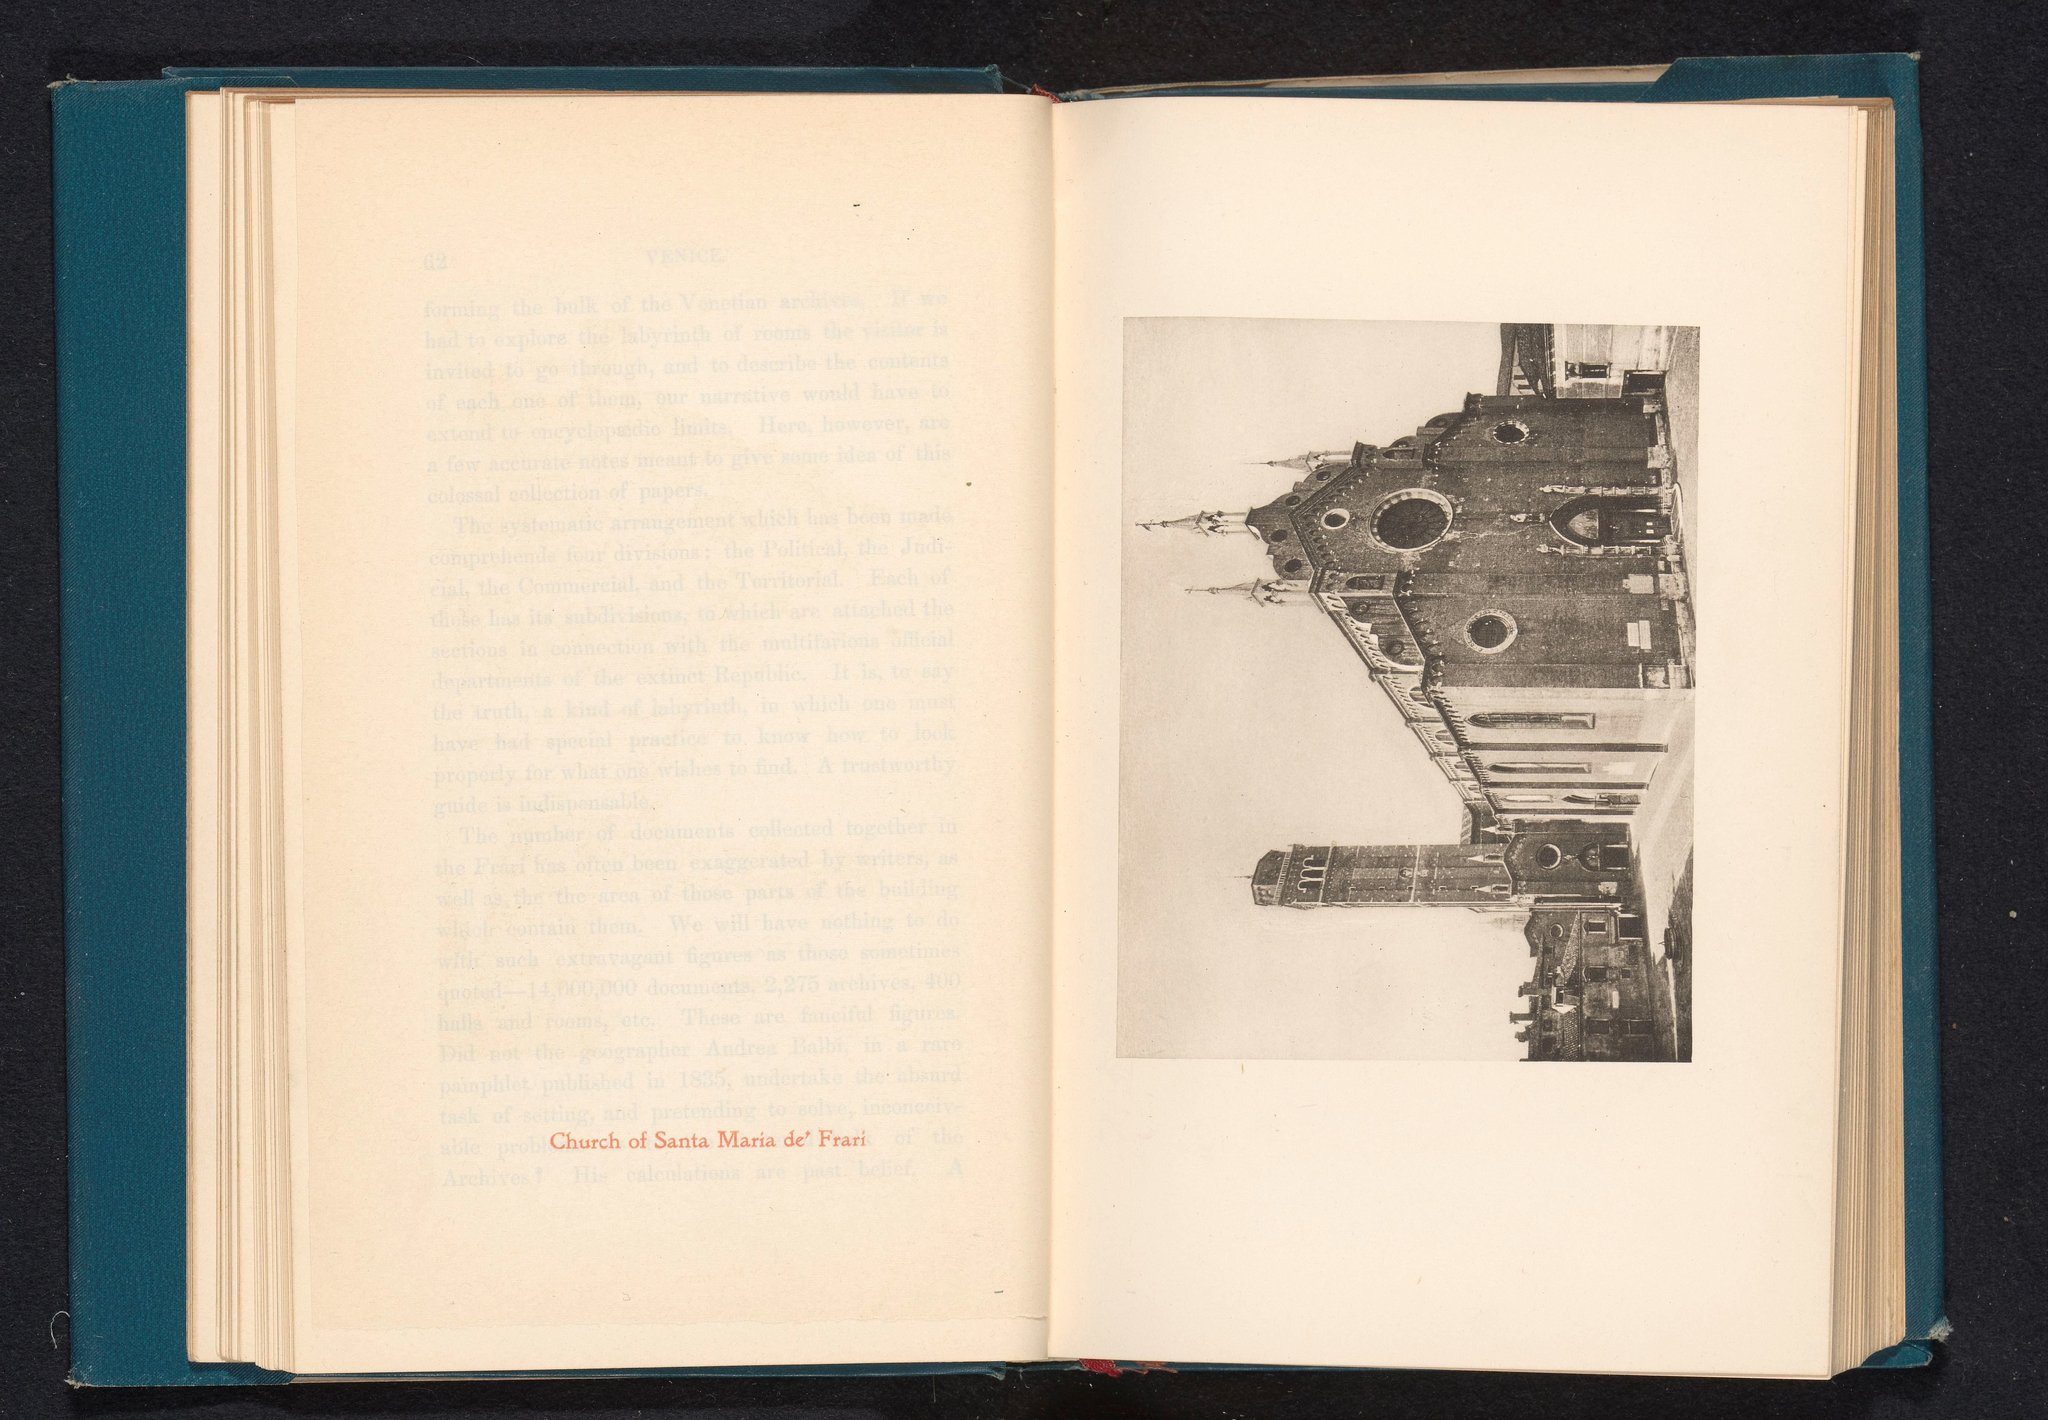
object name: page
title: Exterieur van de Basilica di Santa Maria Gloriosa dei Frari te Venetië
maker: Anonymous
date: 1882-1892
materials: paper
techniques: photoaquatint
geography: venice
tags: church (exterior), façade (of house or building)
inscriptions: title: ‘Church of Santa Maria de' Frari’